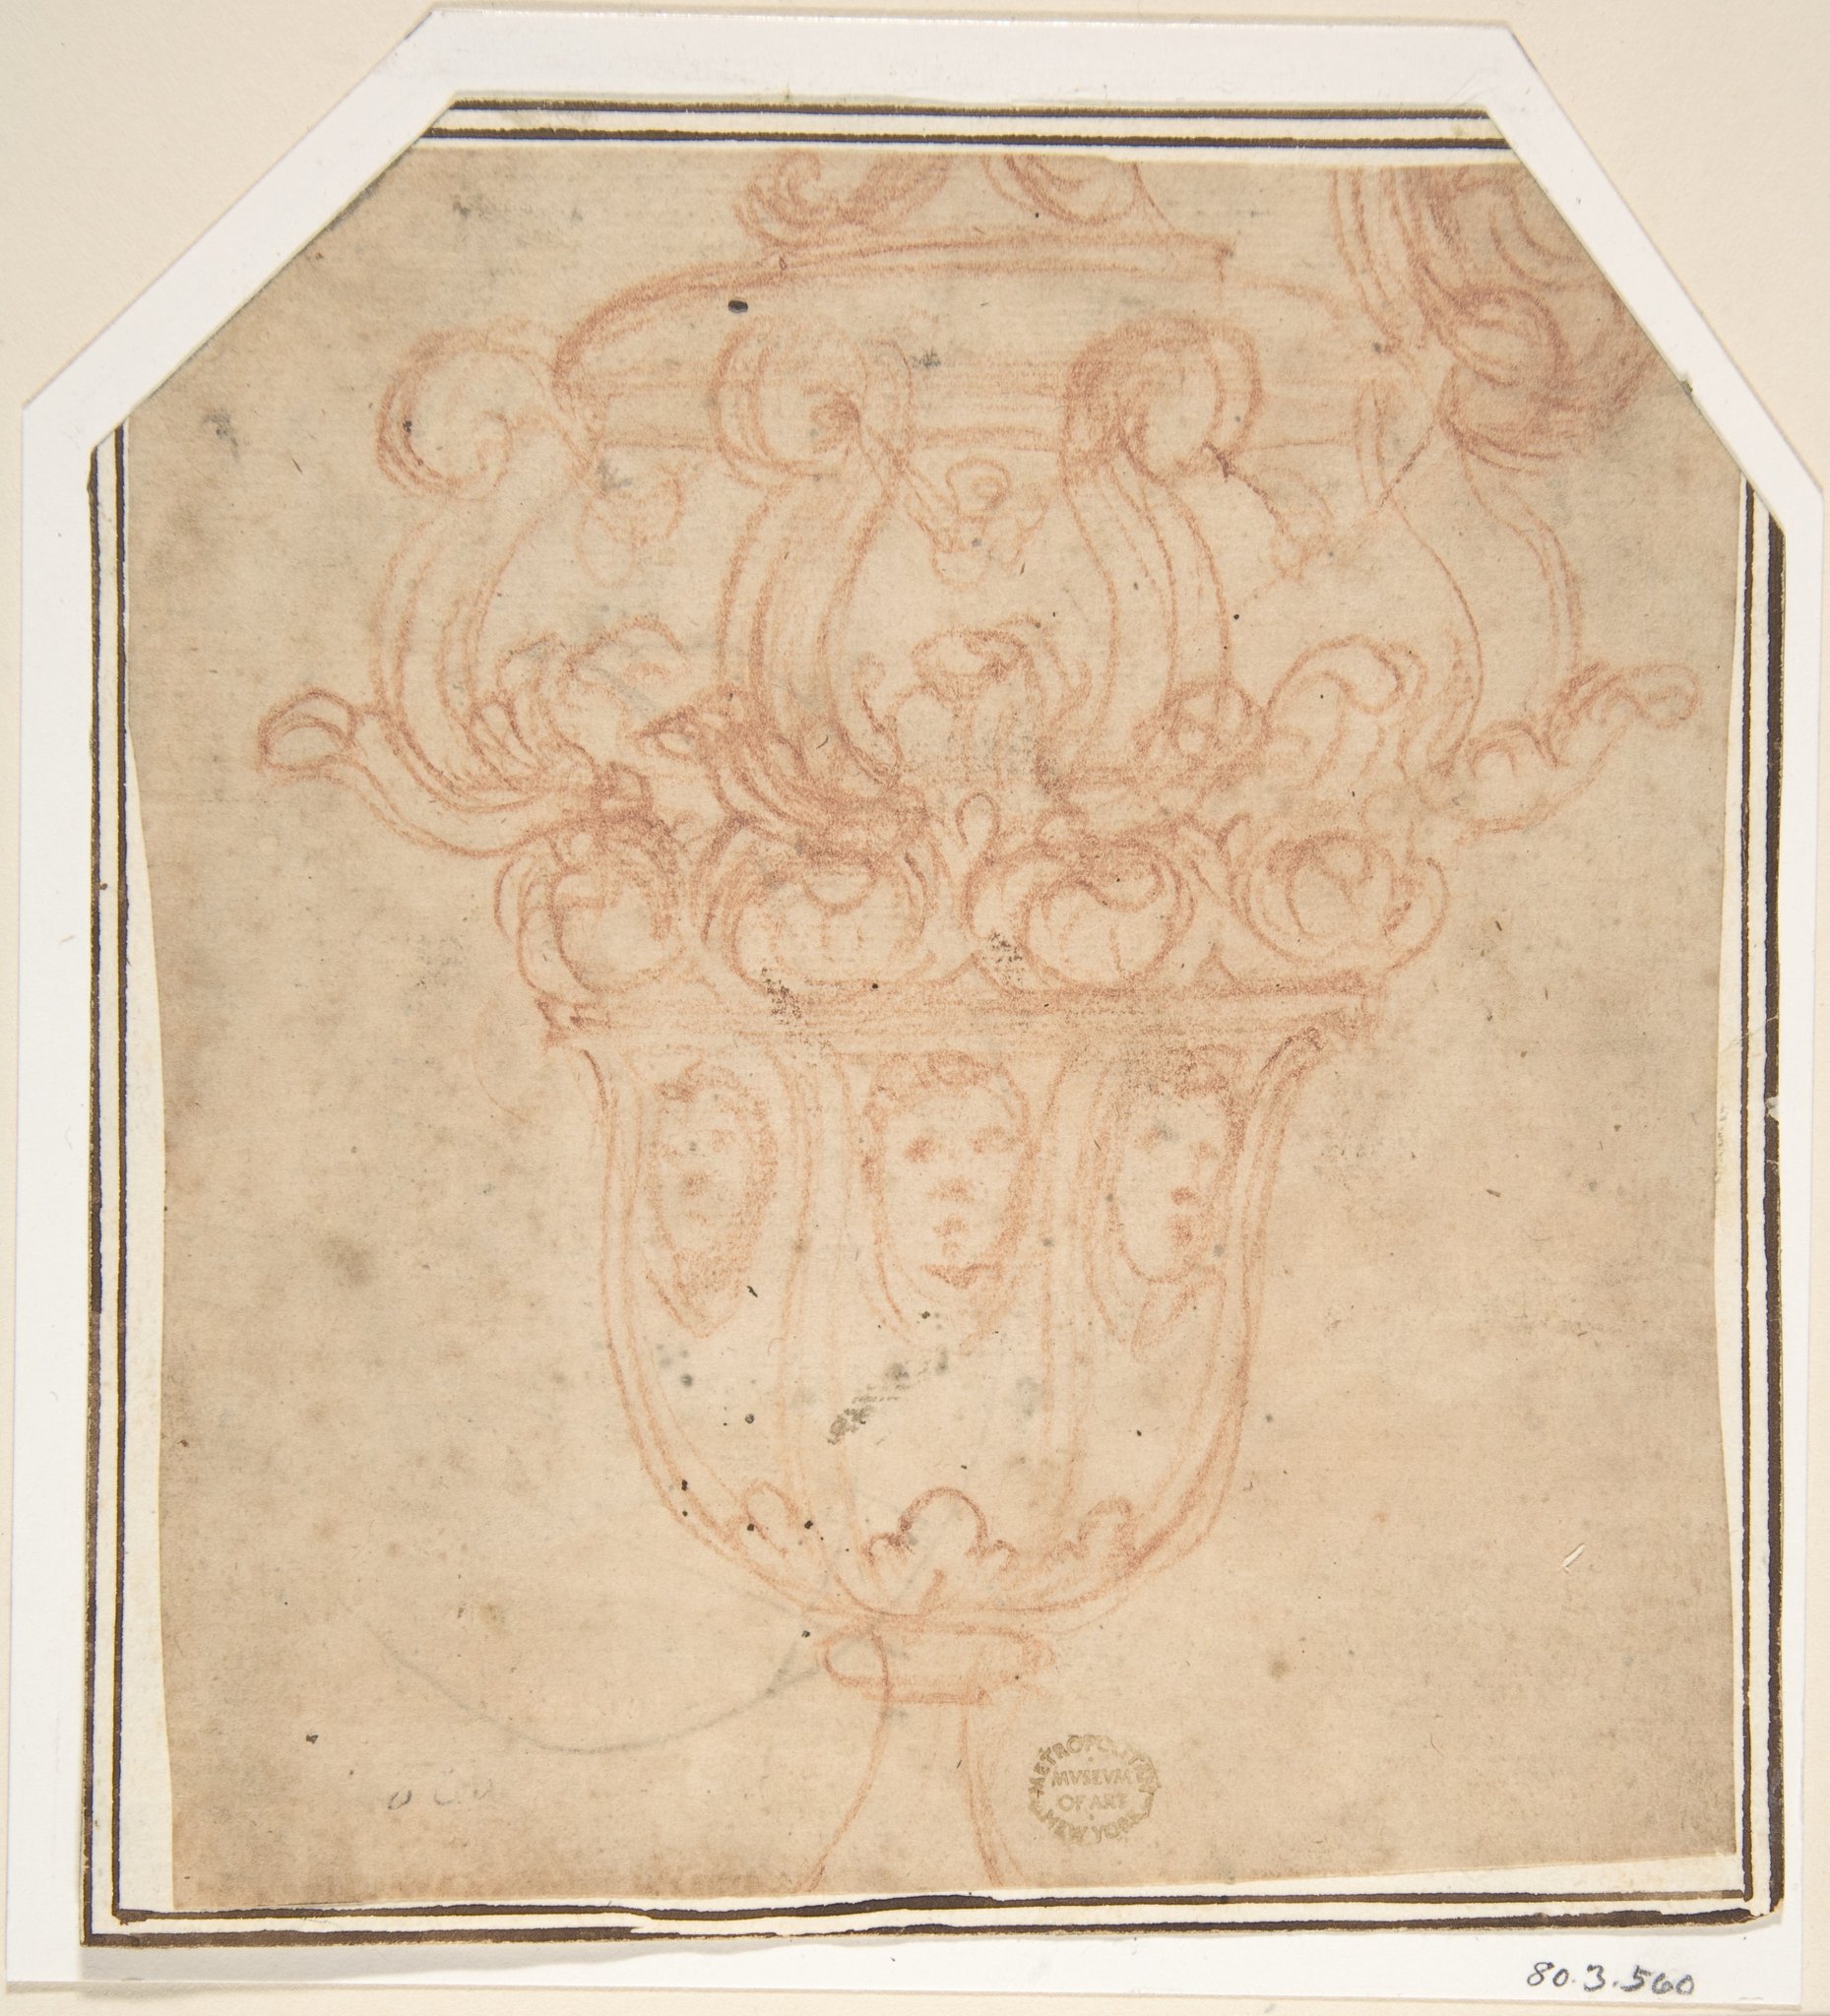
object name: drawing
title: Vase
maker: anonymous, italian, 16th century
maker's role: artist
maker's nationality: italian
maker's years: 1550-1600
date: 1501-1600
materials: chalk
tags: vases